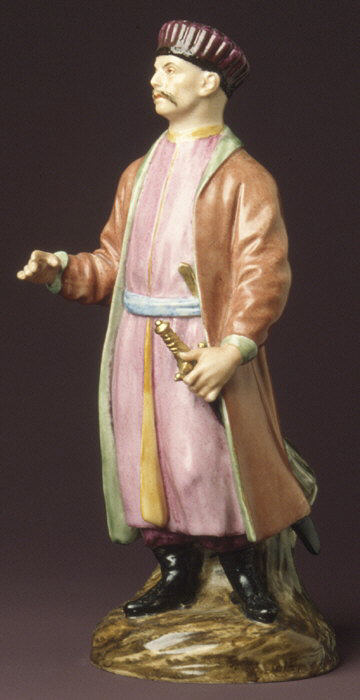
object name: figure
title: Karbadian Man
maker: imperial porcelain manufactory, st. petersburg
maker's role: manufactory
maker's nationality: russian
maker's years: 1744-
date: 1780-1800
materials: hard paste porcelain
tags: men